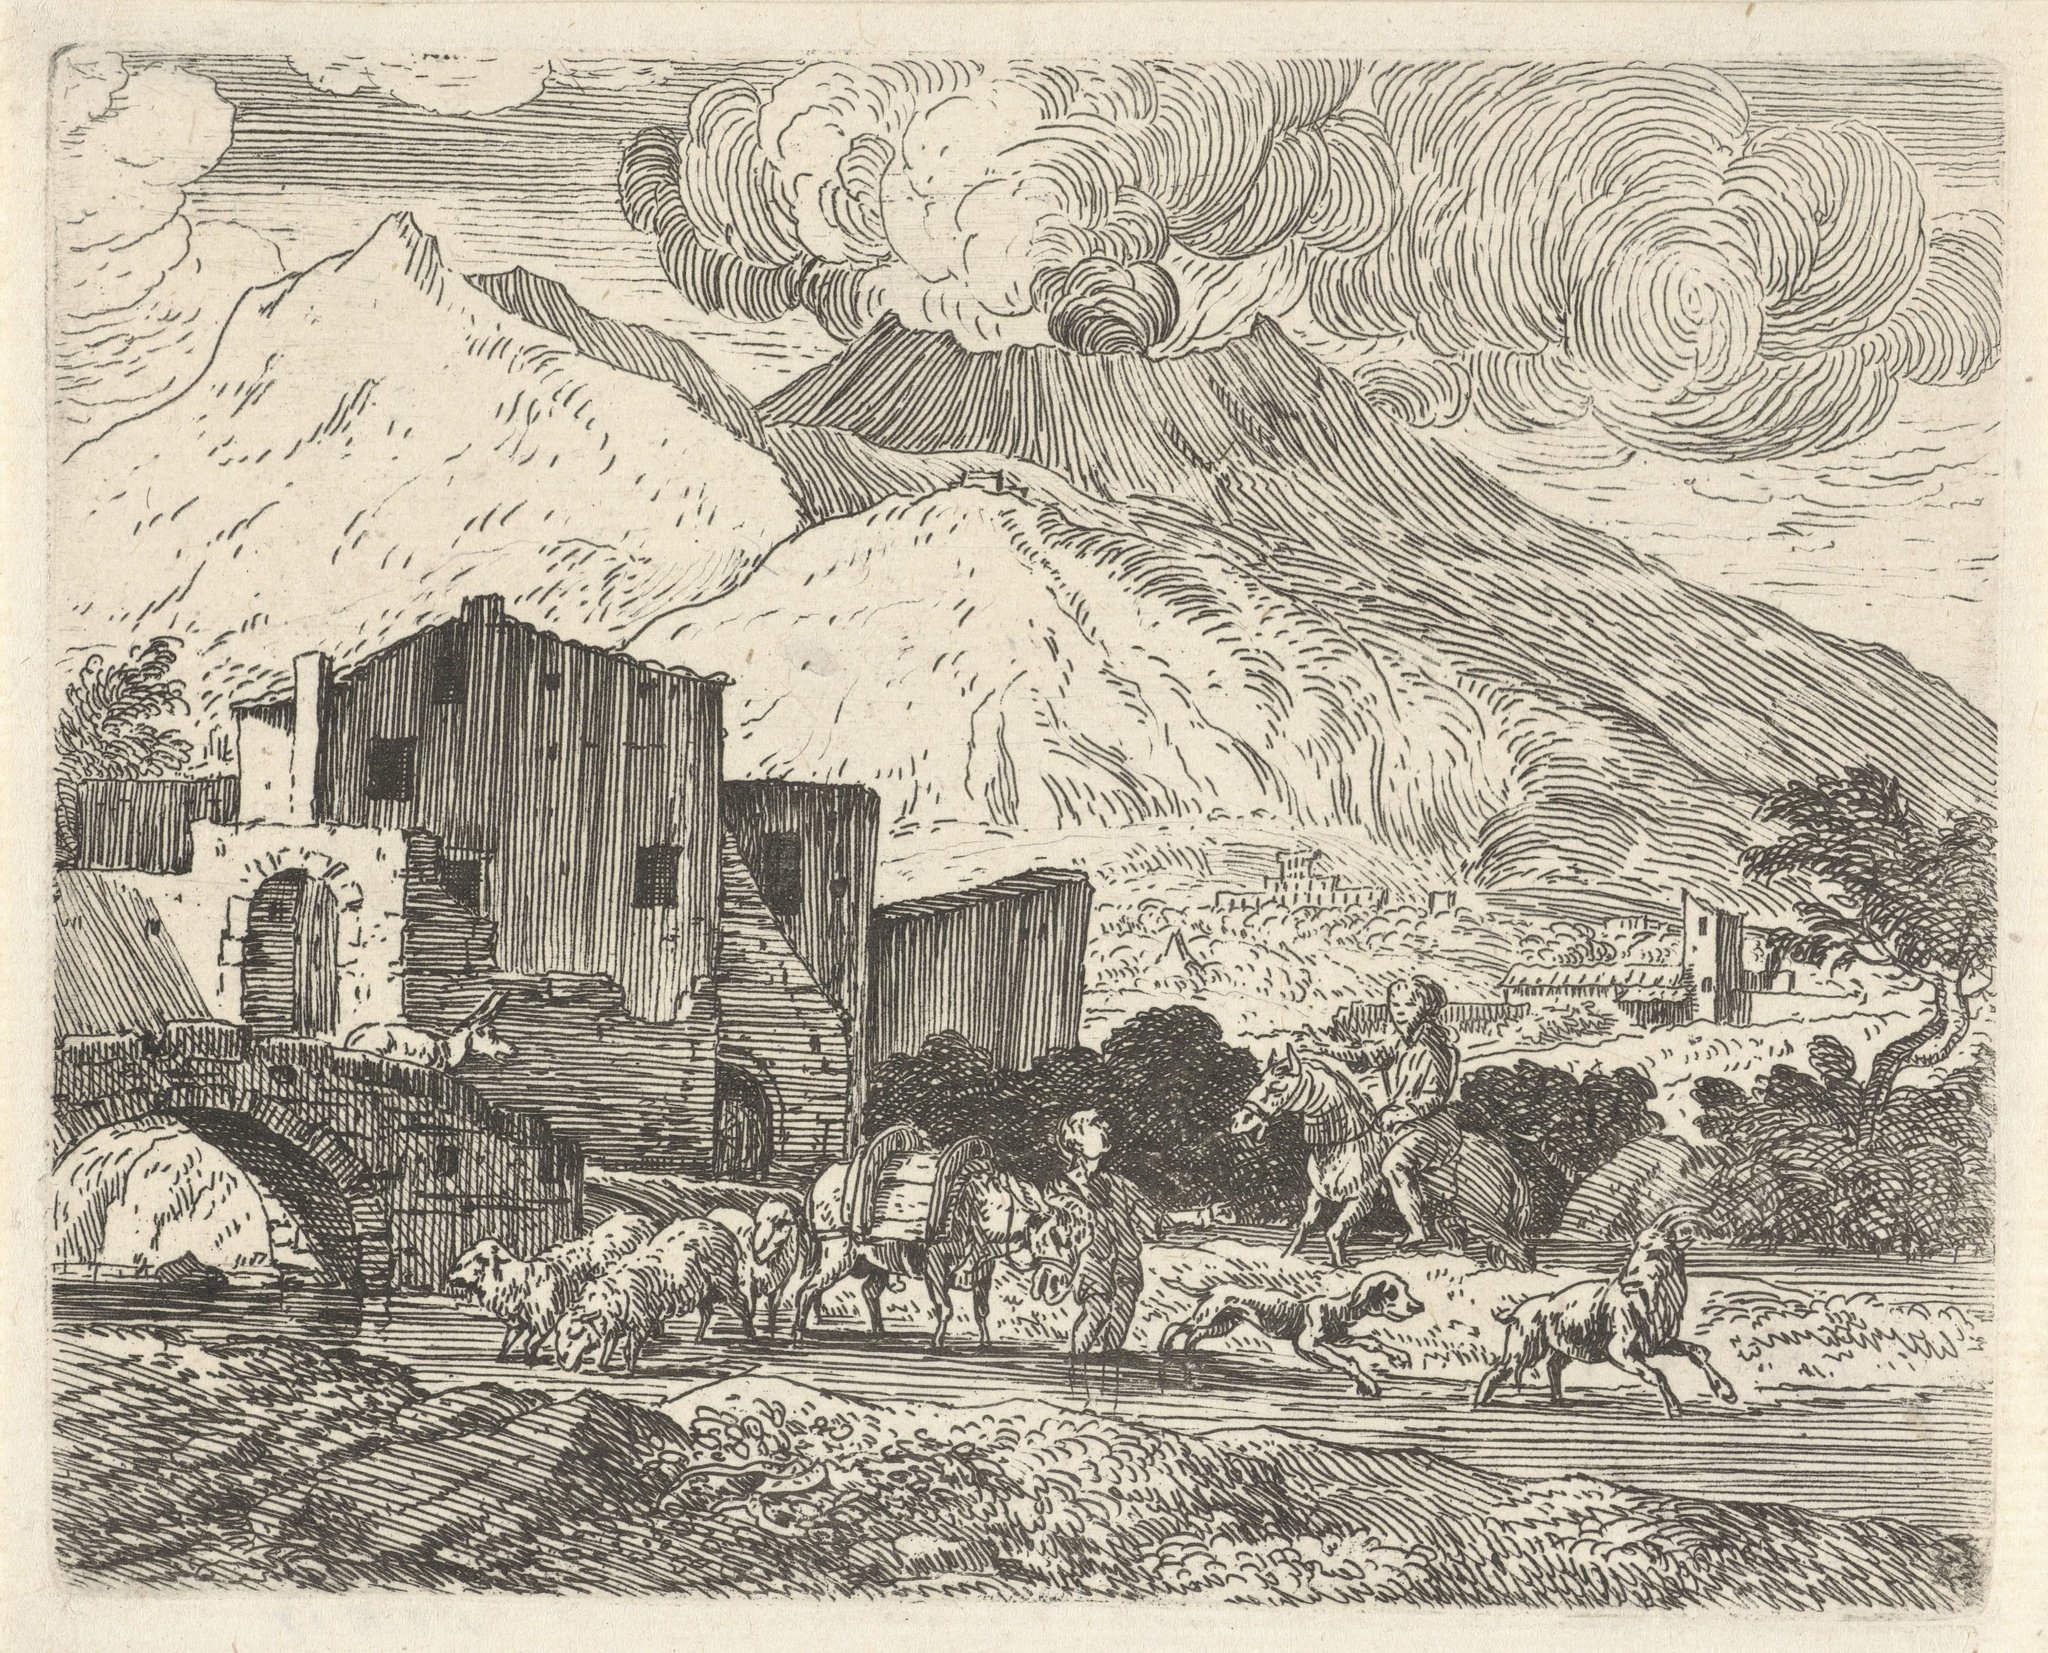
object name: print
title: Italiaanse landschappen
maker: govert van der leeuw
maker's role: print maker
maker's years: 1645-1688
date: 1655-1688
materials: paper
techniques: etching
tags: herding, herdsman, herdswoman, shepherd, shepherdess, cowherd, etc., volcano, mountains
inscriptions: collector's mark: Lugt 240, collector's mark: Lugt 1920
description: Een herder staat met een kleine kudde bij stroompje in een bergachtig landschap. Links liggen huizen, rechts rookt in de verte een vulkaan. De prent maakt deel uit van een negendelige serie prenten met voorstellingen van Italiaanse landschappen.